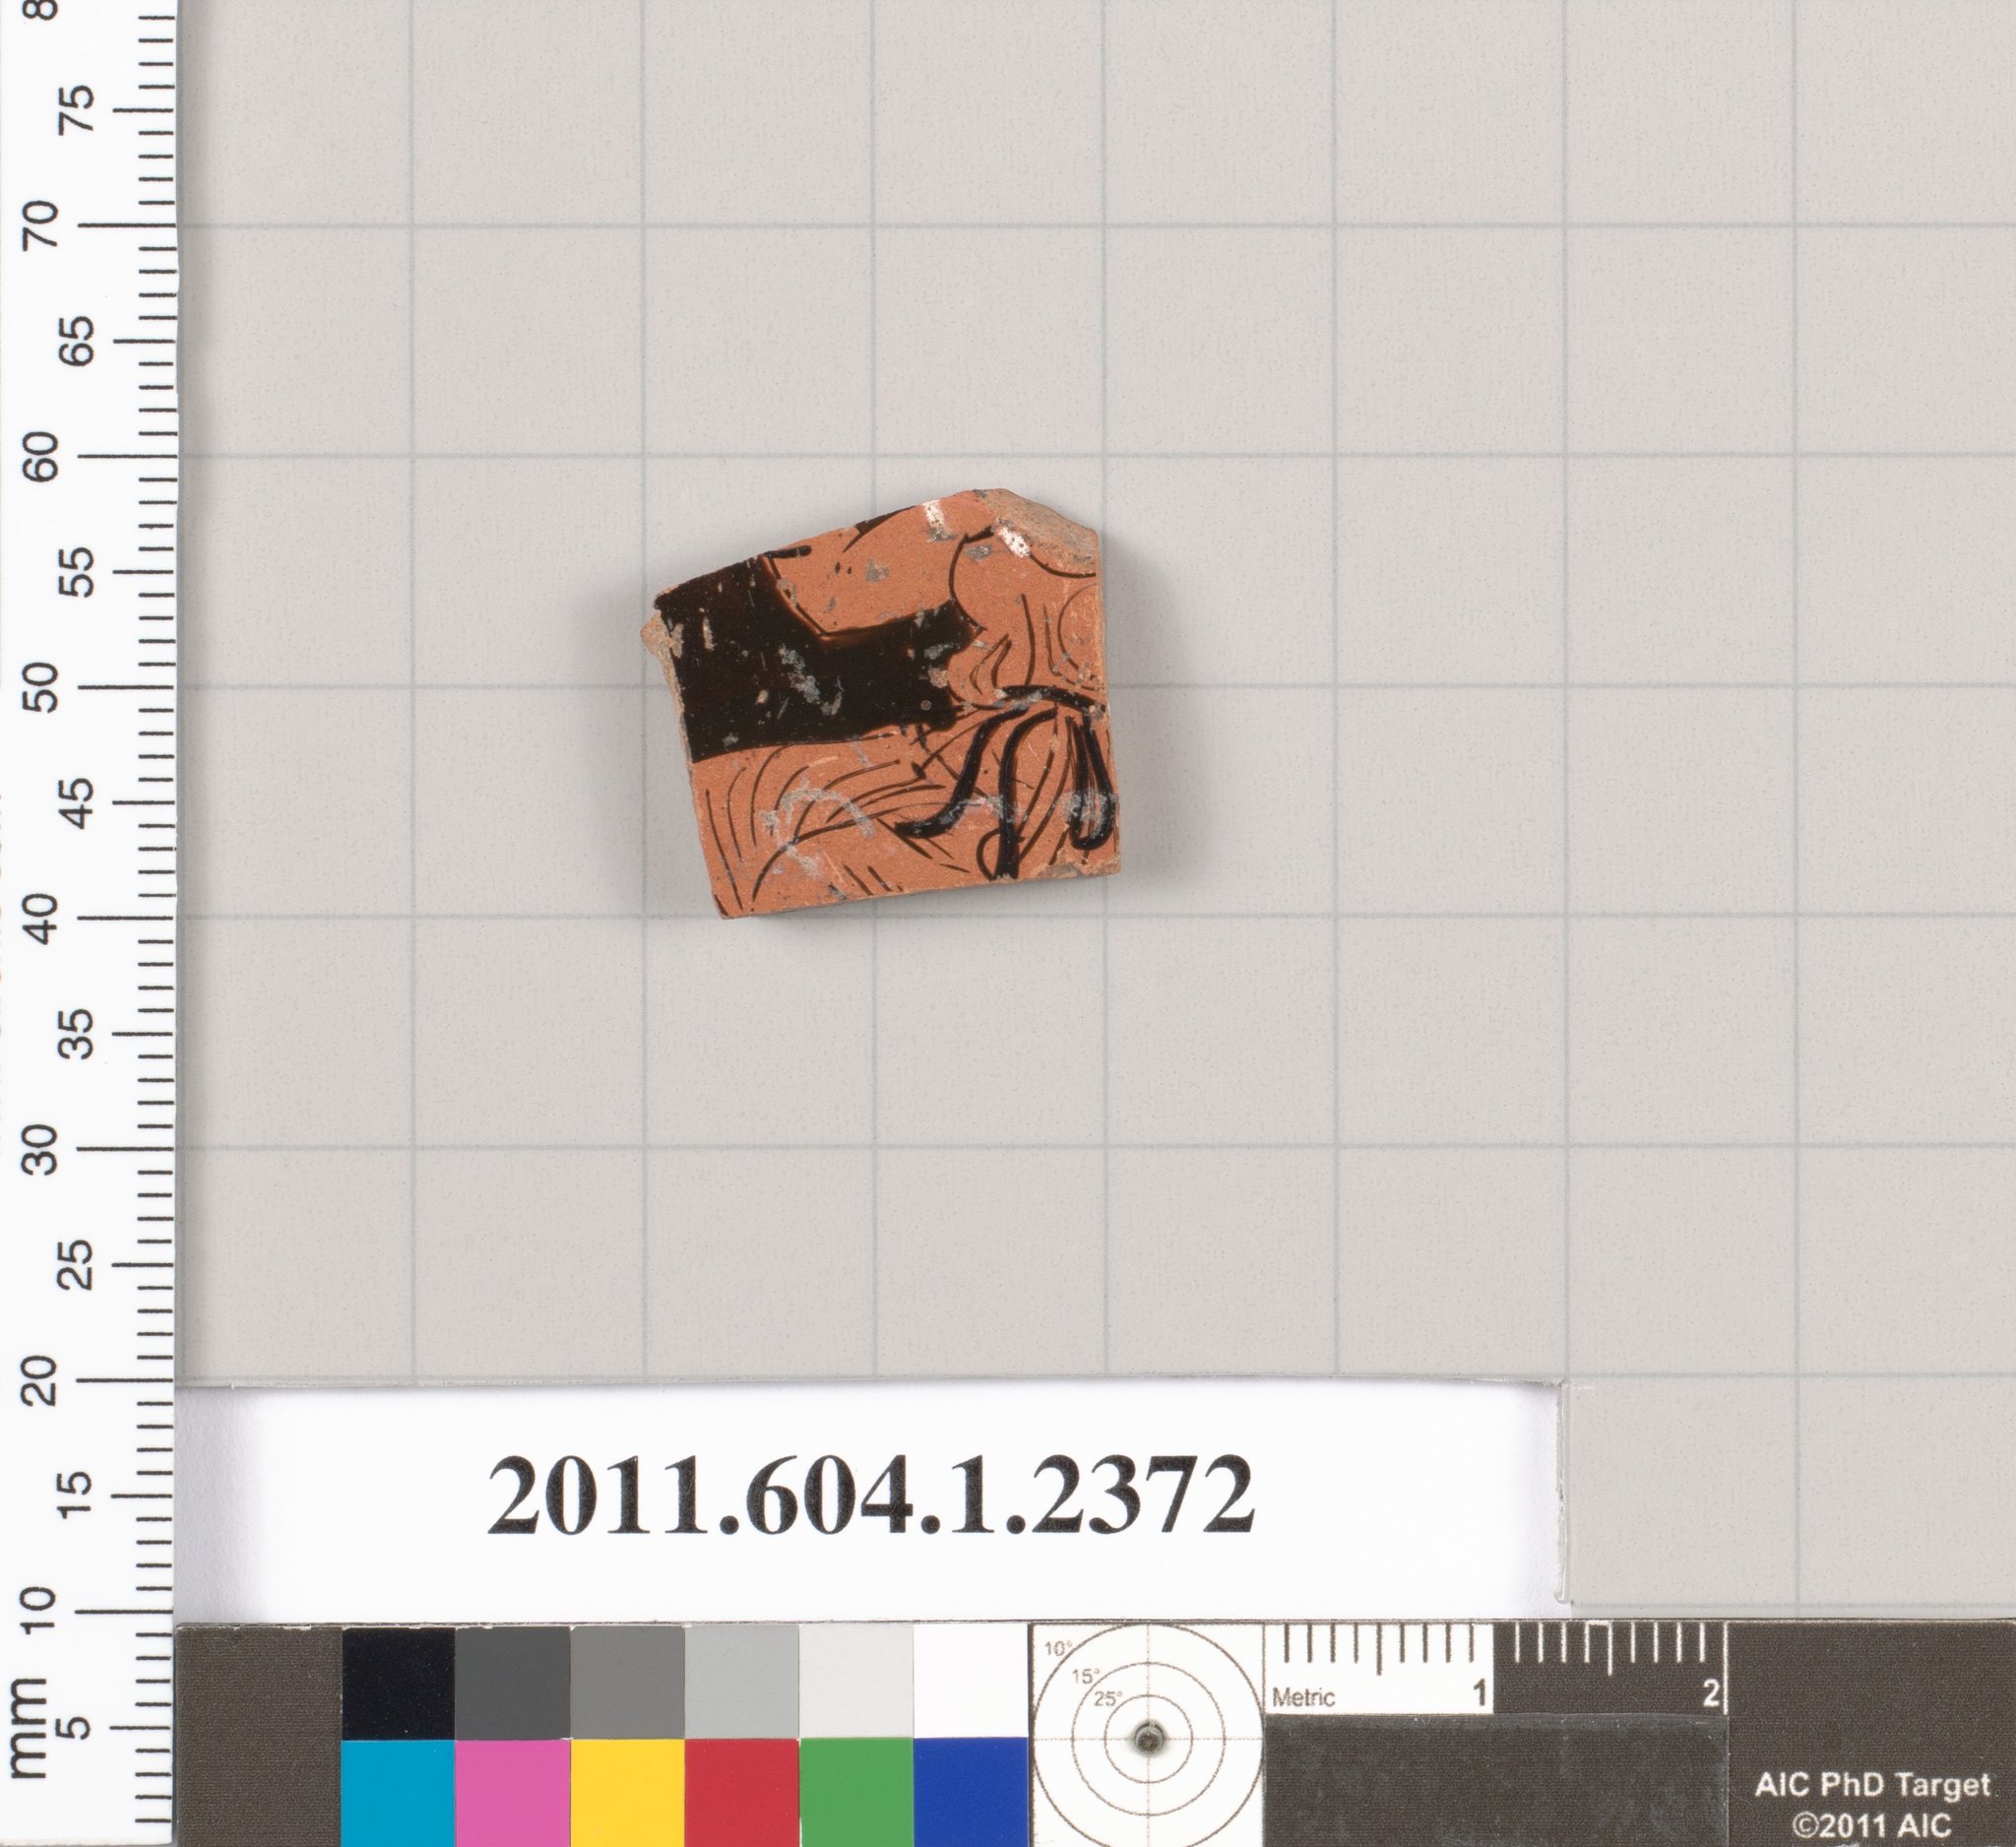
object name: kylix fragment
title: Terracotta fragment of a kylix (drinking cup)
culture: greek, attic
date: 450-426 BCE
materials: terracotta